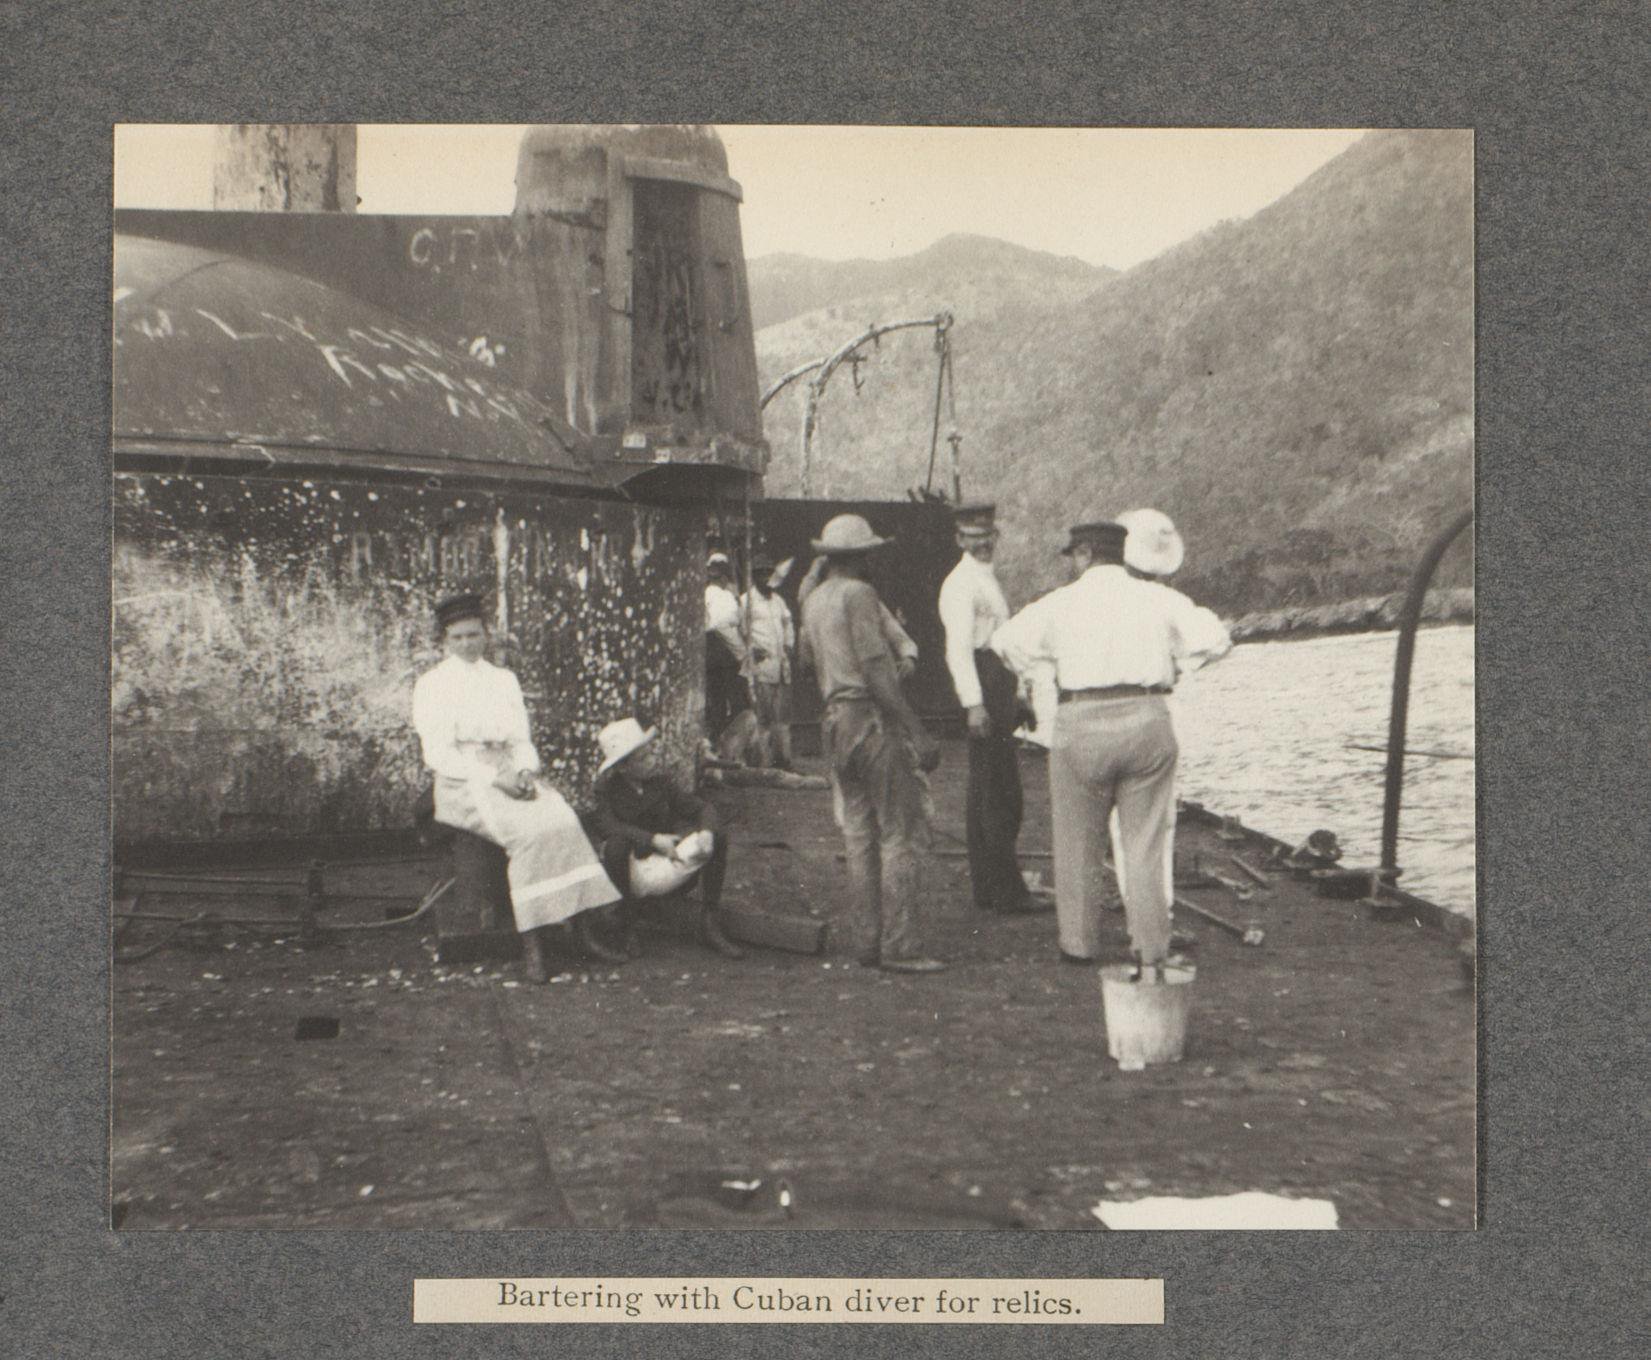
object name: photograph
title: Reisgezelschap in onderhandeling met een Cubaanse duiker voor relieken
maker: Anonymous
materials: paper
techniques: platinum process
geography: santiago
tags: deep-sea diving, historical persons, shipwreck